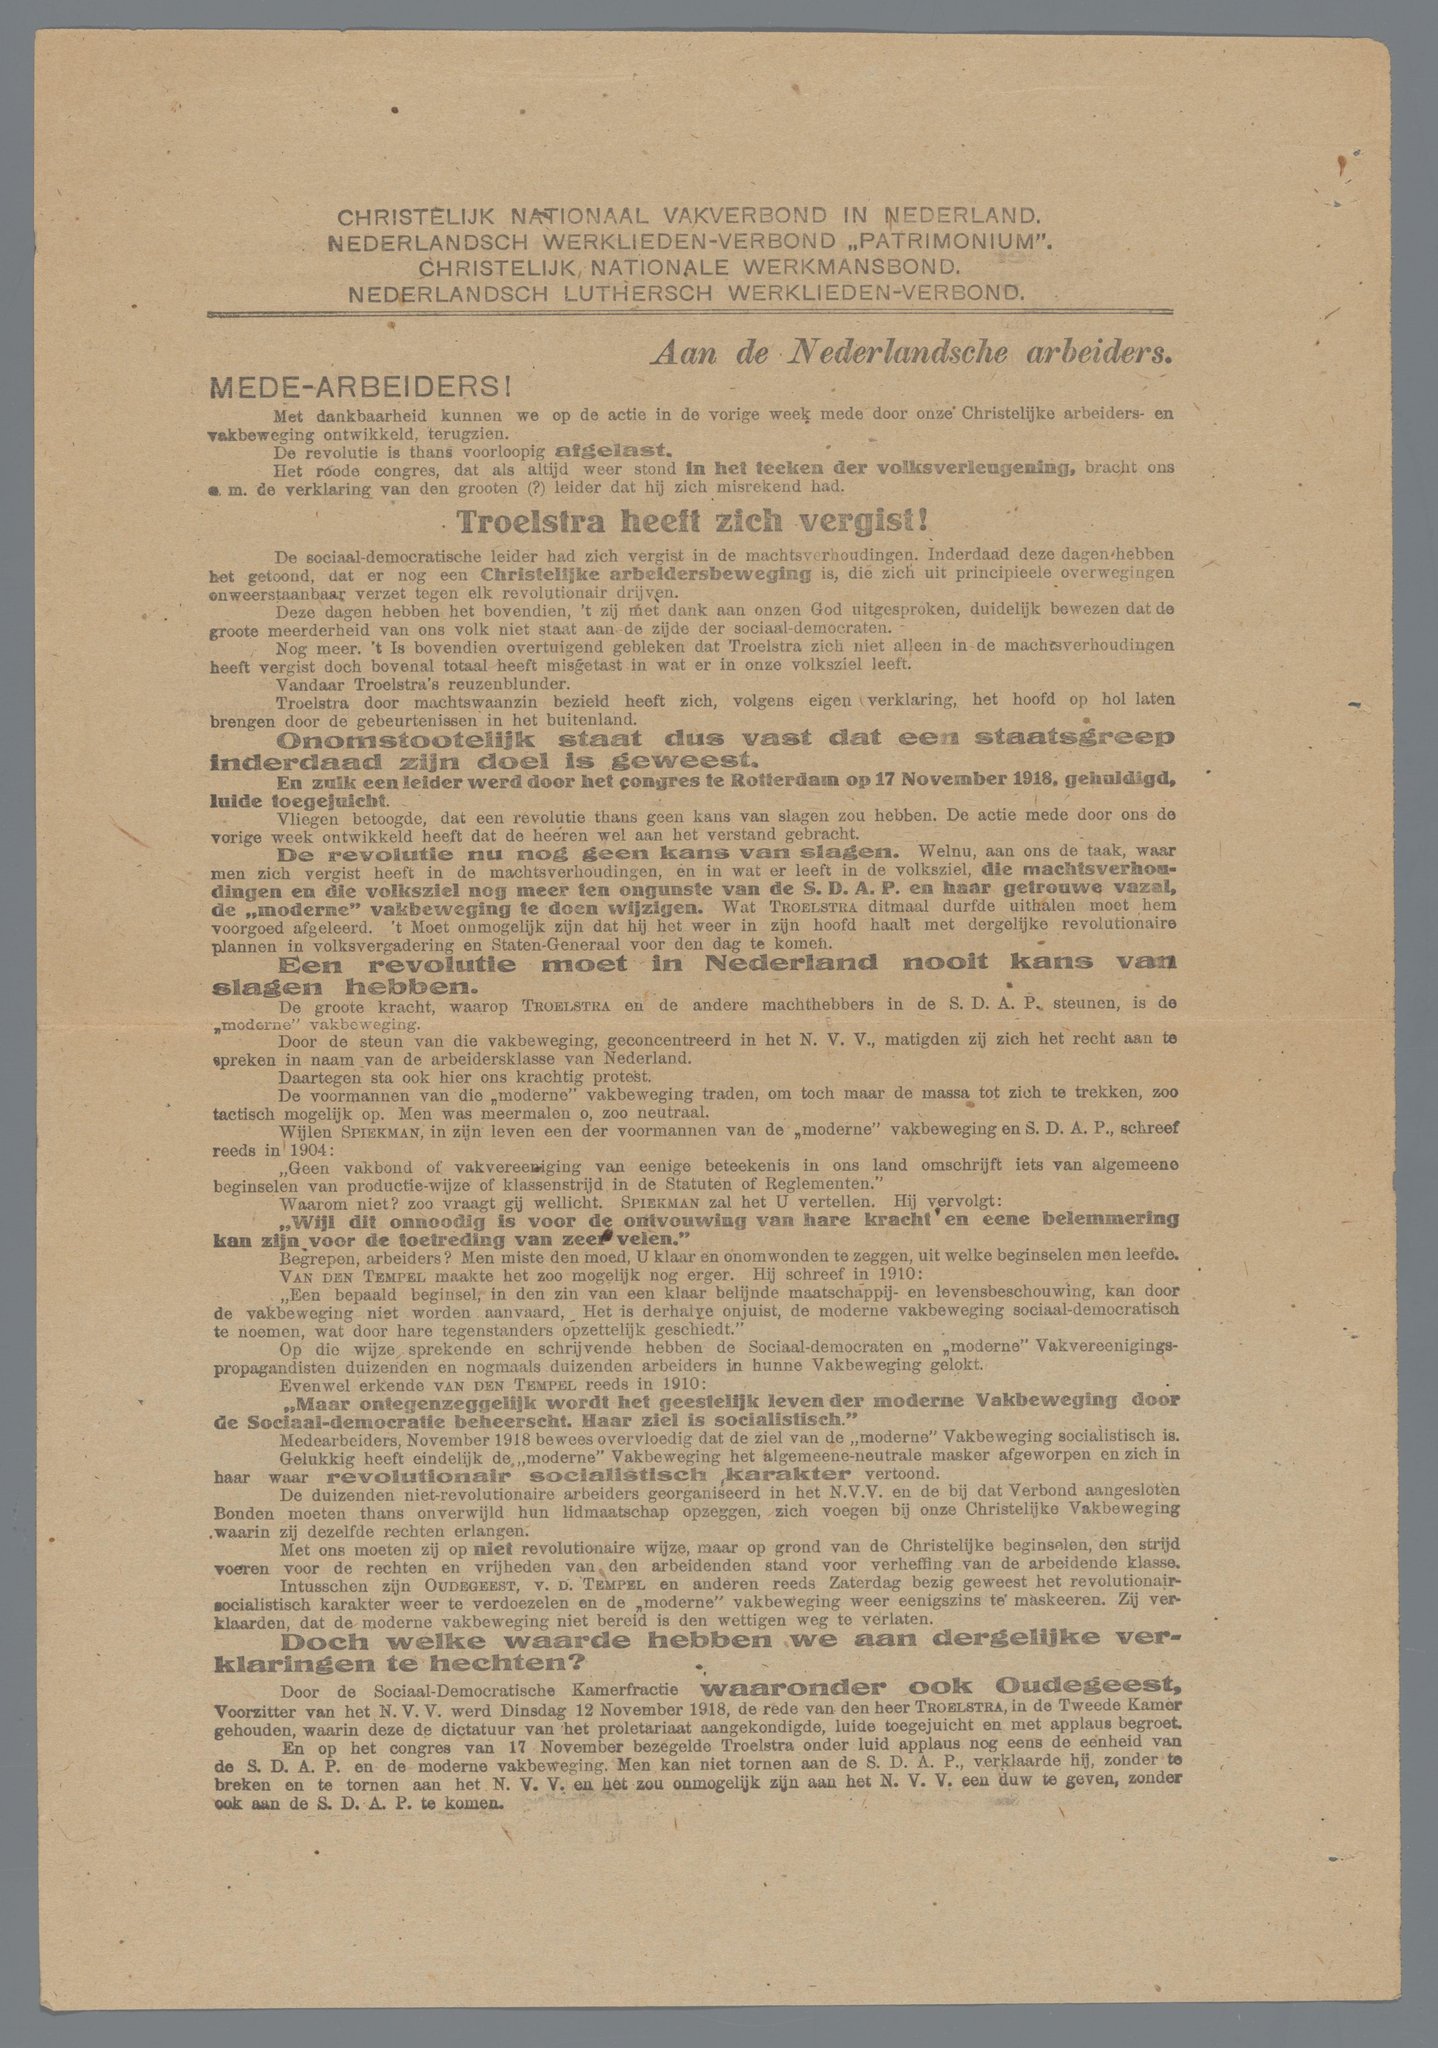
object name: pamphlet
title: Aan de Nederlandsche Arbeiders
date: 1918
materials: paper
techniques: printing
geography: rotterdam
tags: netherlands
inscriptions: date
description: Tweezijdig bedrukt vel papier, in verschillende lettertypen (gericht tegen Troelstra's revolutiestreven). Keerzijde gesigneerd en gedateerd.